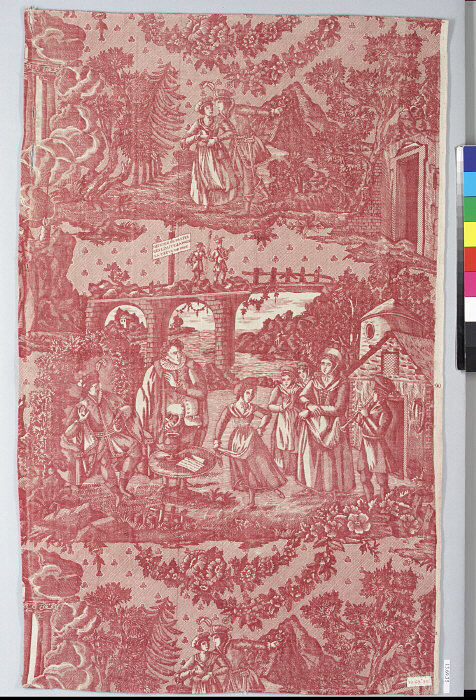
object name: furnishing textile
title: La Trève de Dieu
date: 1825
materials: cotton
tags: bridges,men,women,flowers,trees